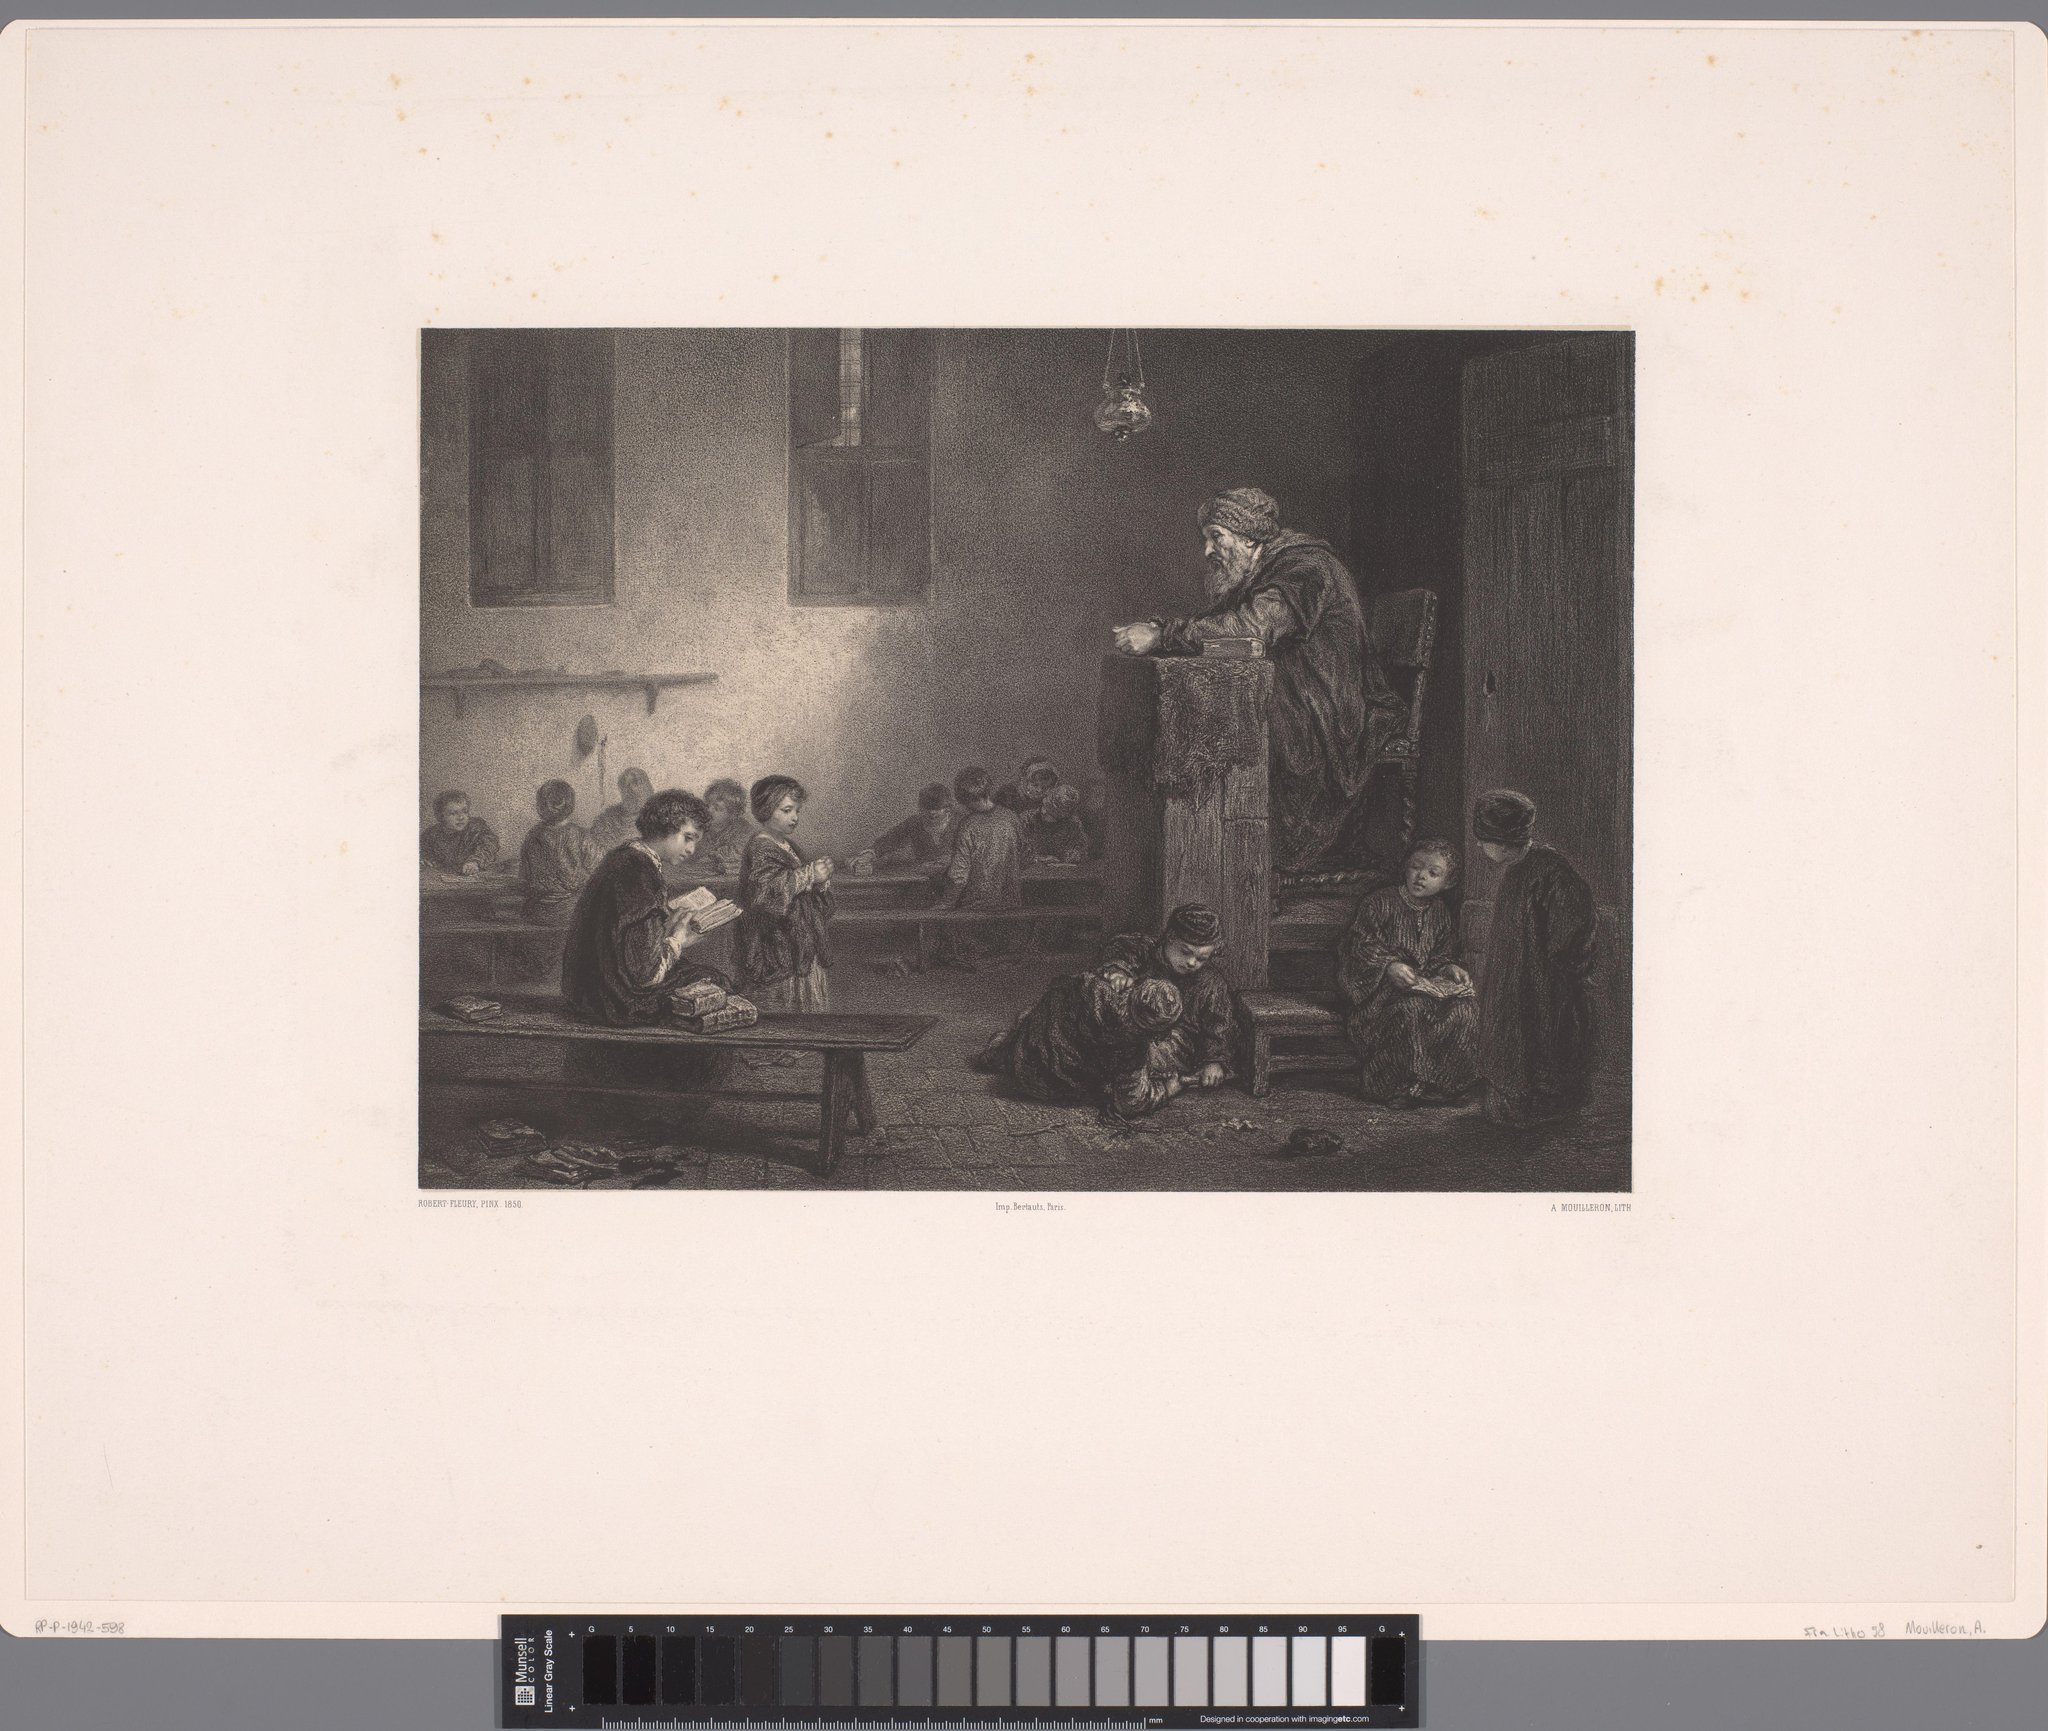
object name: print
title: Joodse school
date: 1850-1880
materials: paper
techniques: lithograph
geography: paris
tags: jewish communities, elementary school; class, form